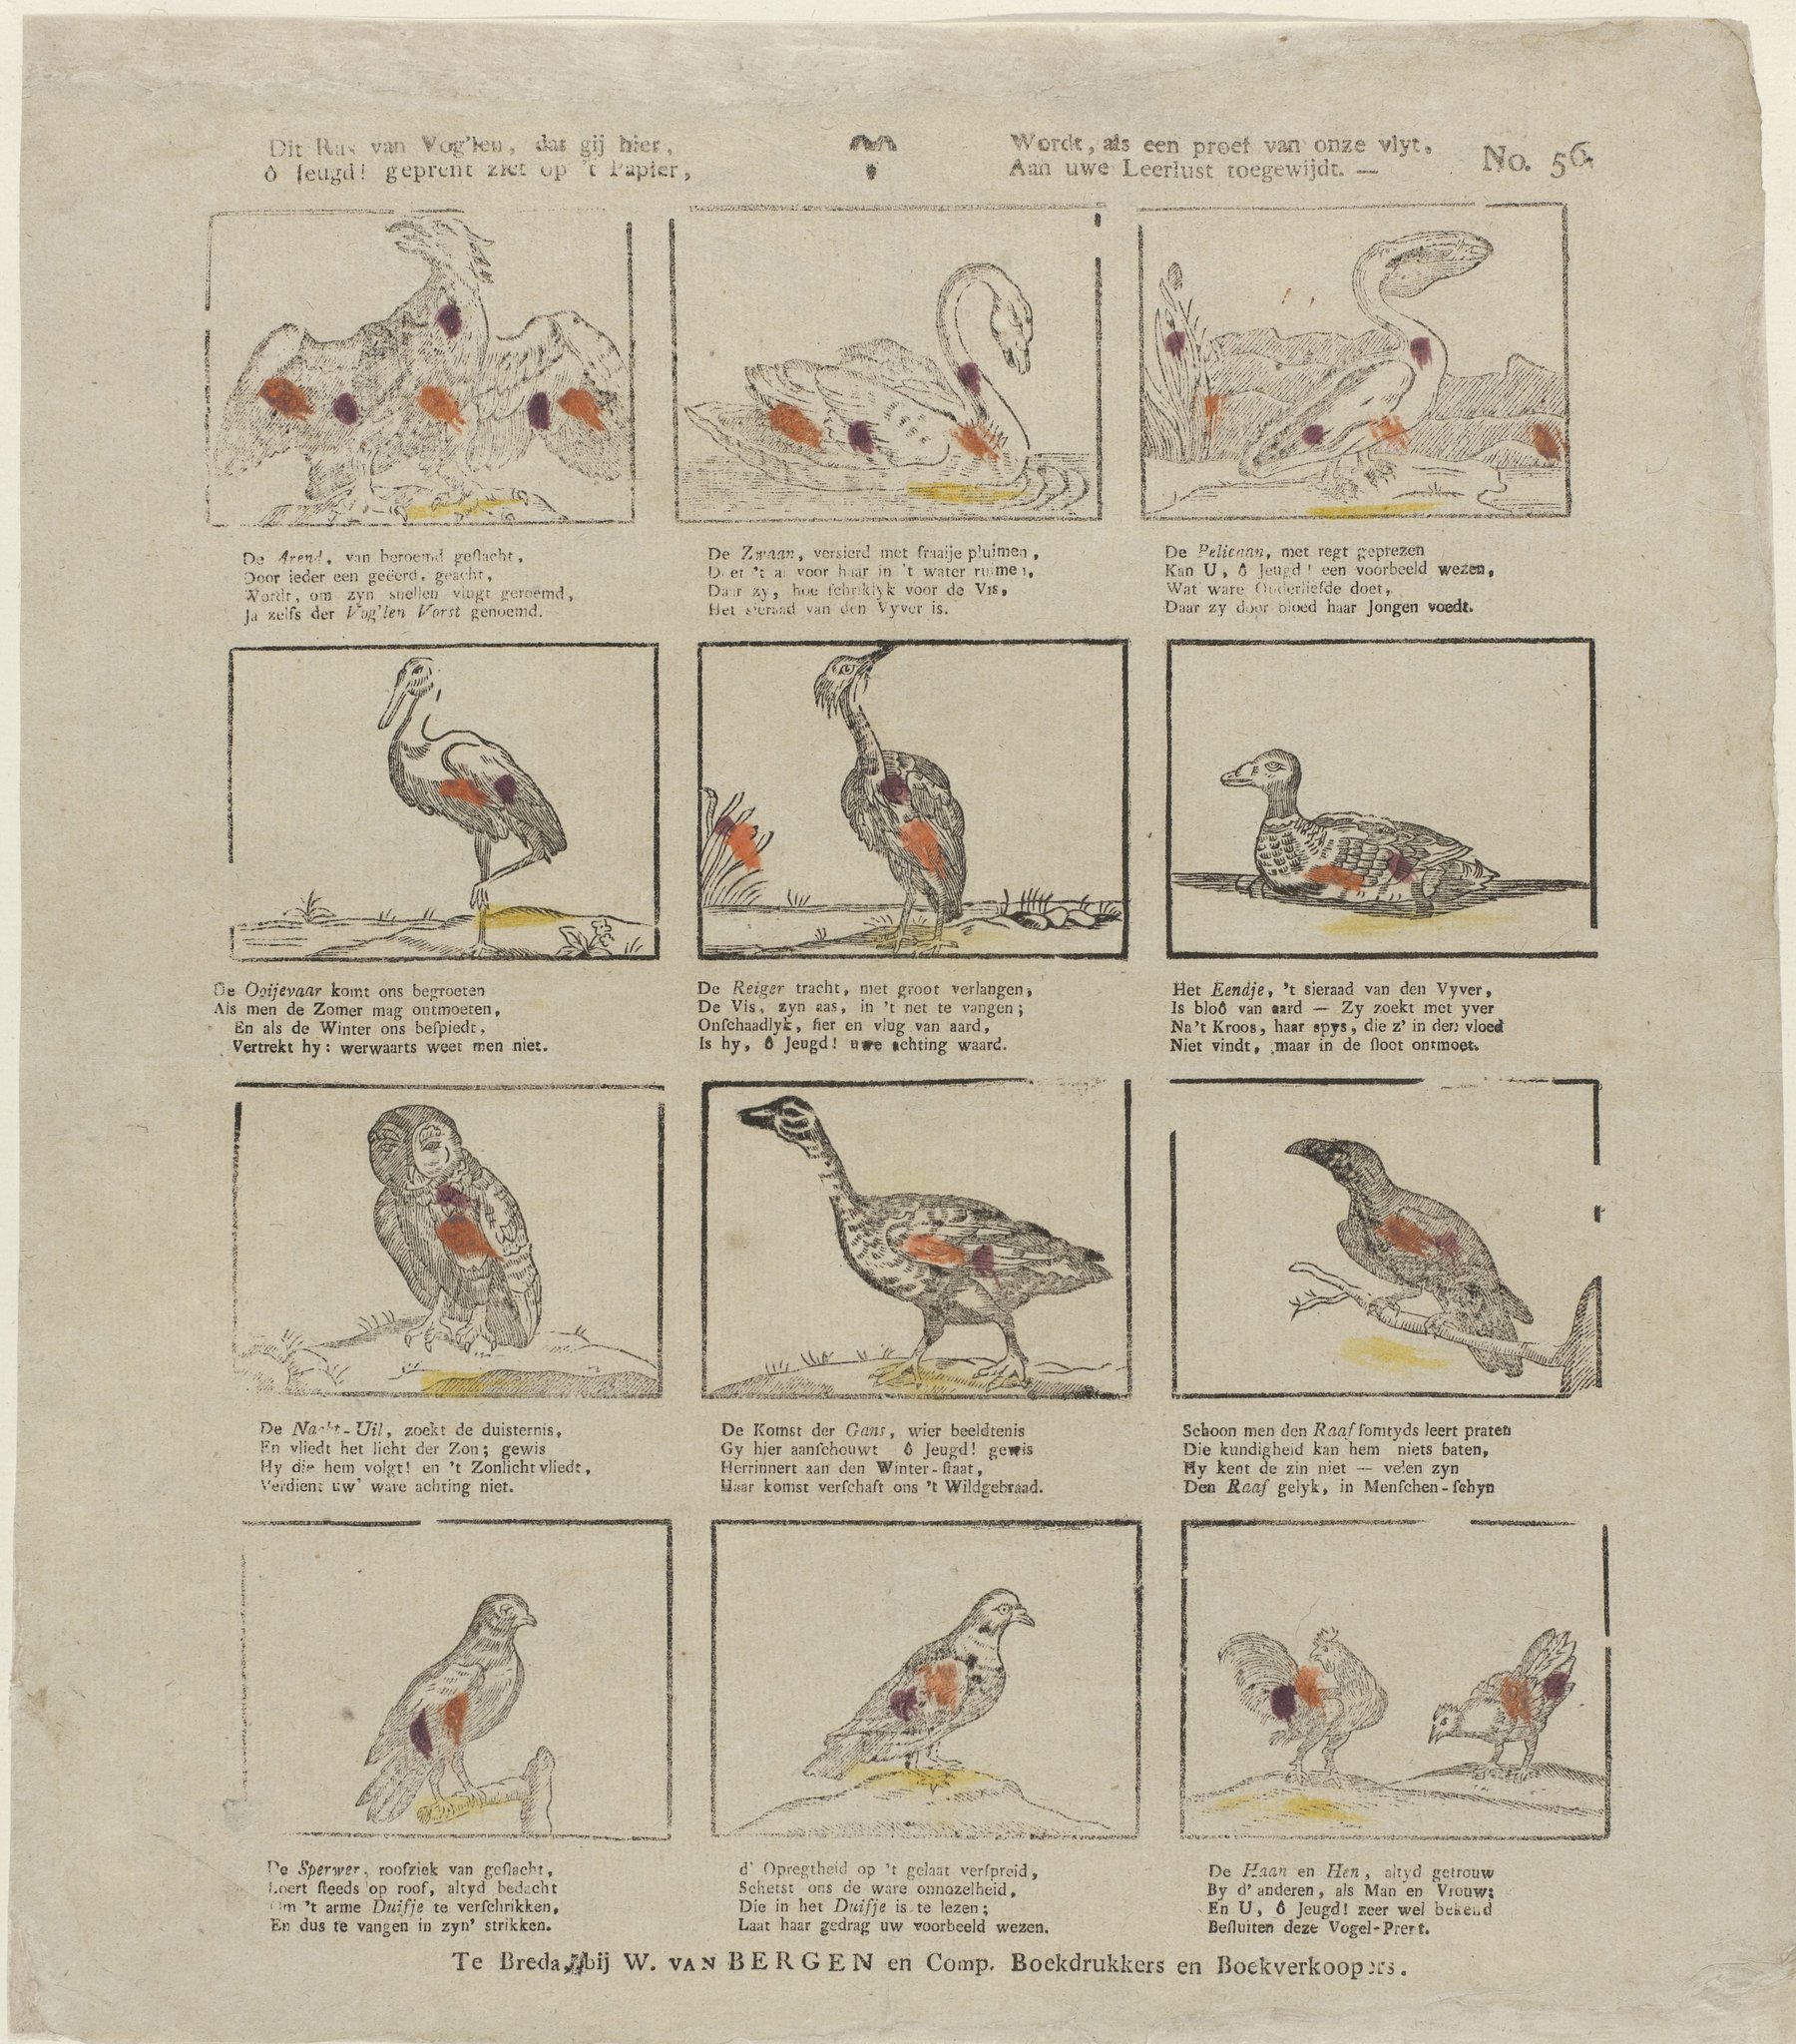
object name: popular print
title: Dit ras van vog'len, dat gij hier, / ô jeugd! geprent ziet op 't papier, / Wordt, als een proef van onze vlyt, / Aan uwe leerlust toegewijdt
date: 1818-1828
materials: paper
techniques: colour, letterpress printing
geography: breda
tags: birds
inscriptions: collector's mark: Lugt 2760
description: Blad met 12 voorstellingen van vogels, zoals een zwaan, een uil en een duif. Onder elke afbeelding een vierregelig vers. Genummerd rechtsboven: No. 56.